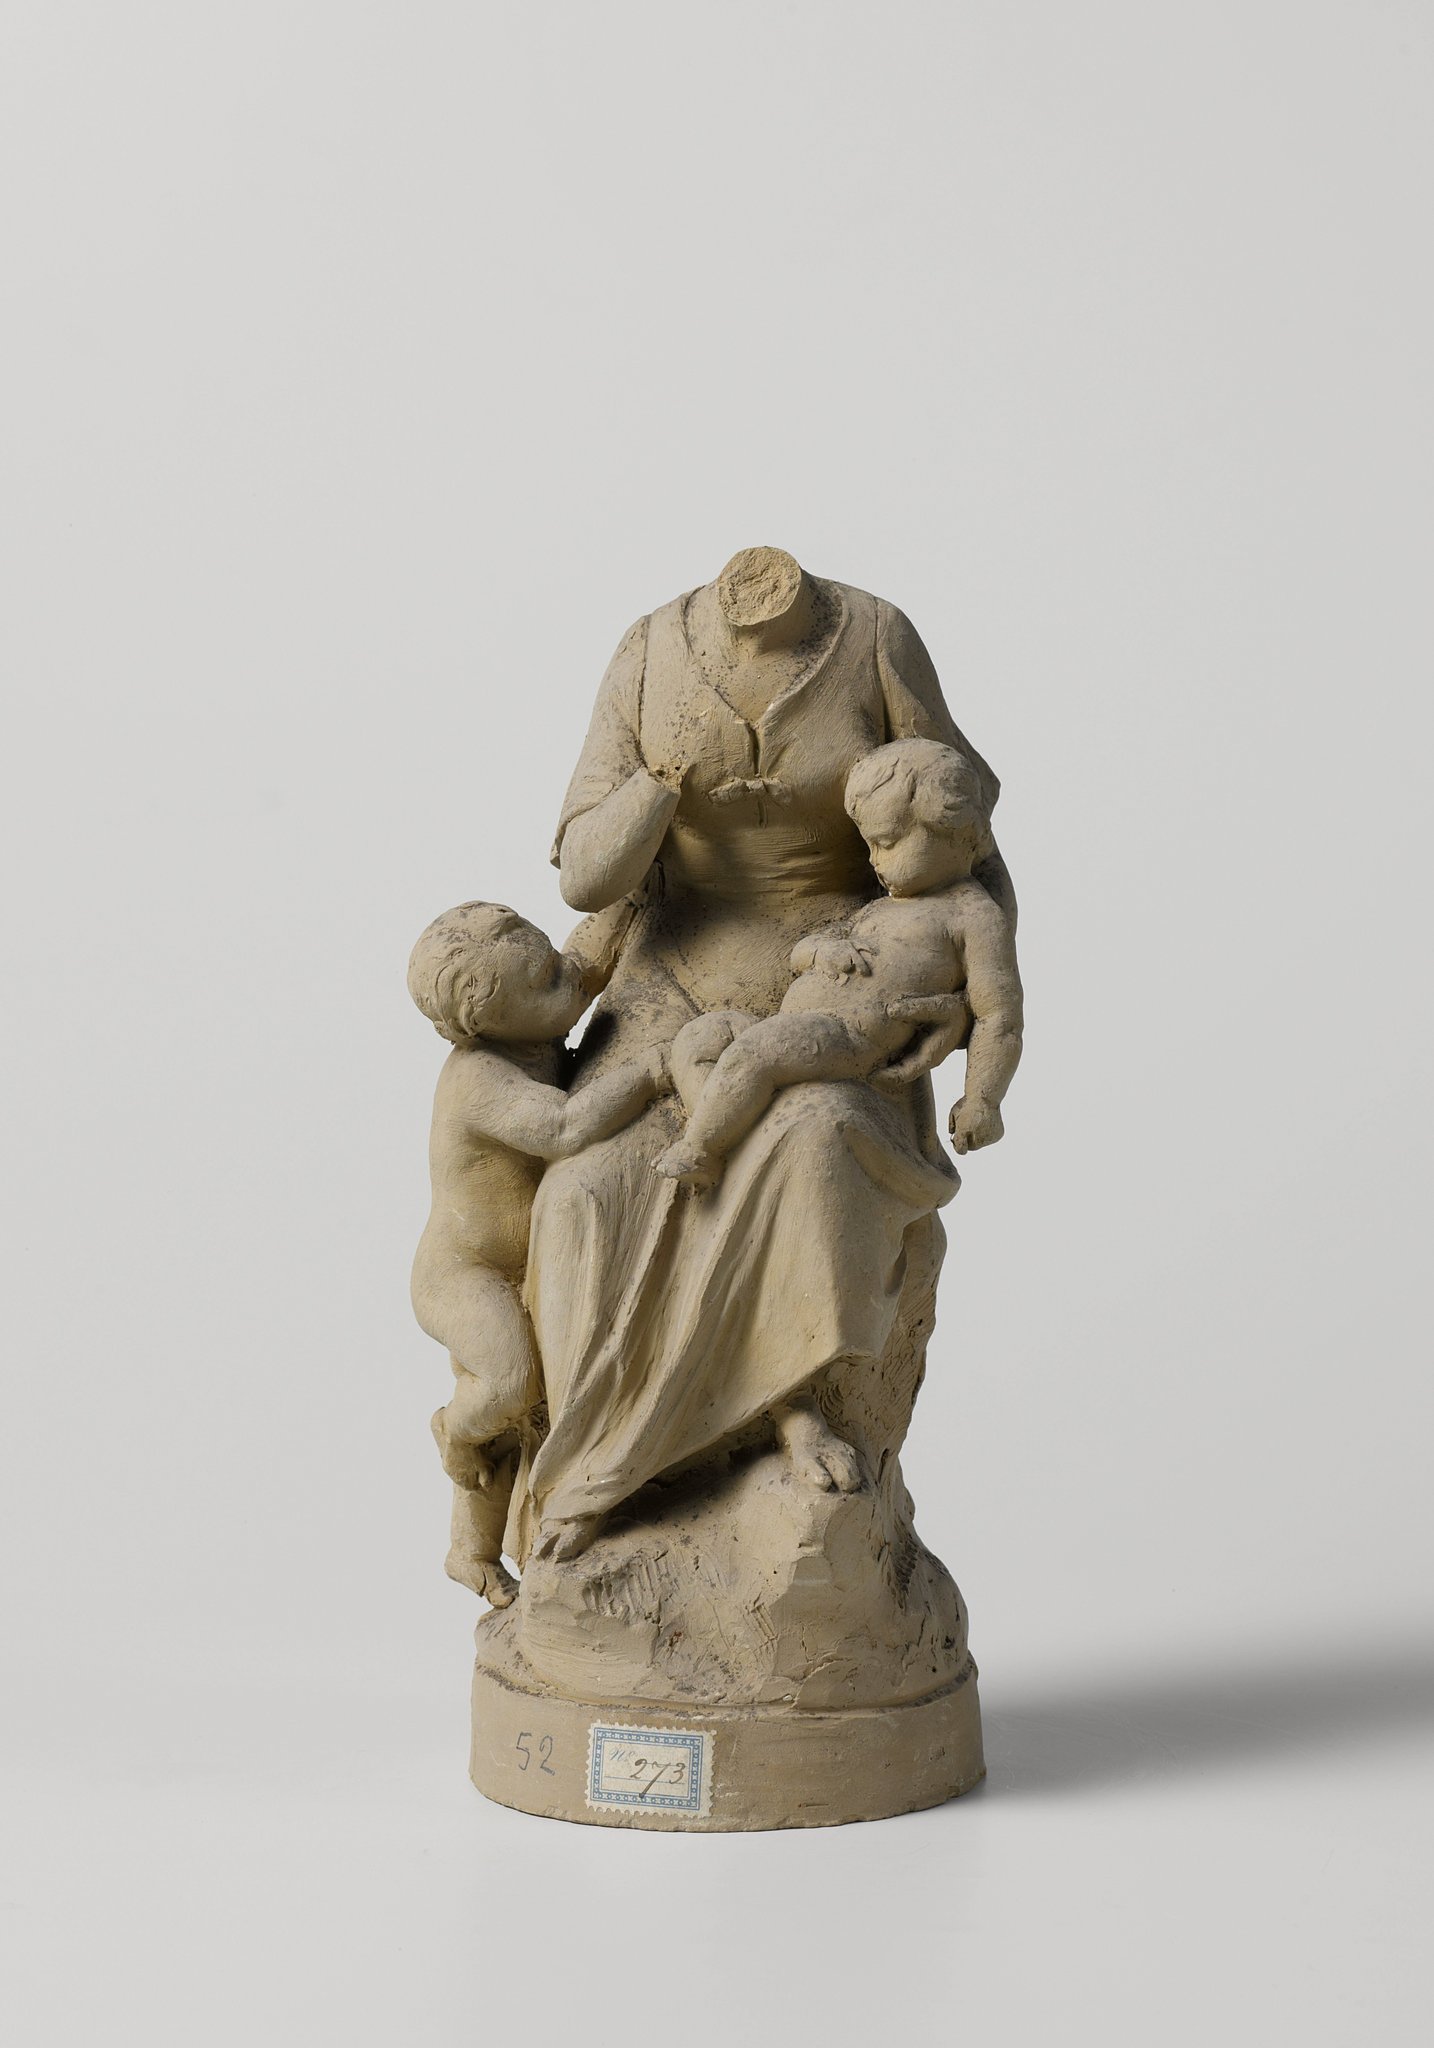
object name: sculpture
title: Moeder met twee kinderen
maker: eugène lacomblé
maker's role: draughtsman, painter, sculptor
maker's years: 1828-1905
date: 1881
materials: clay